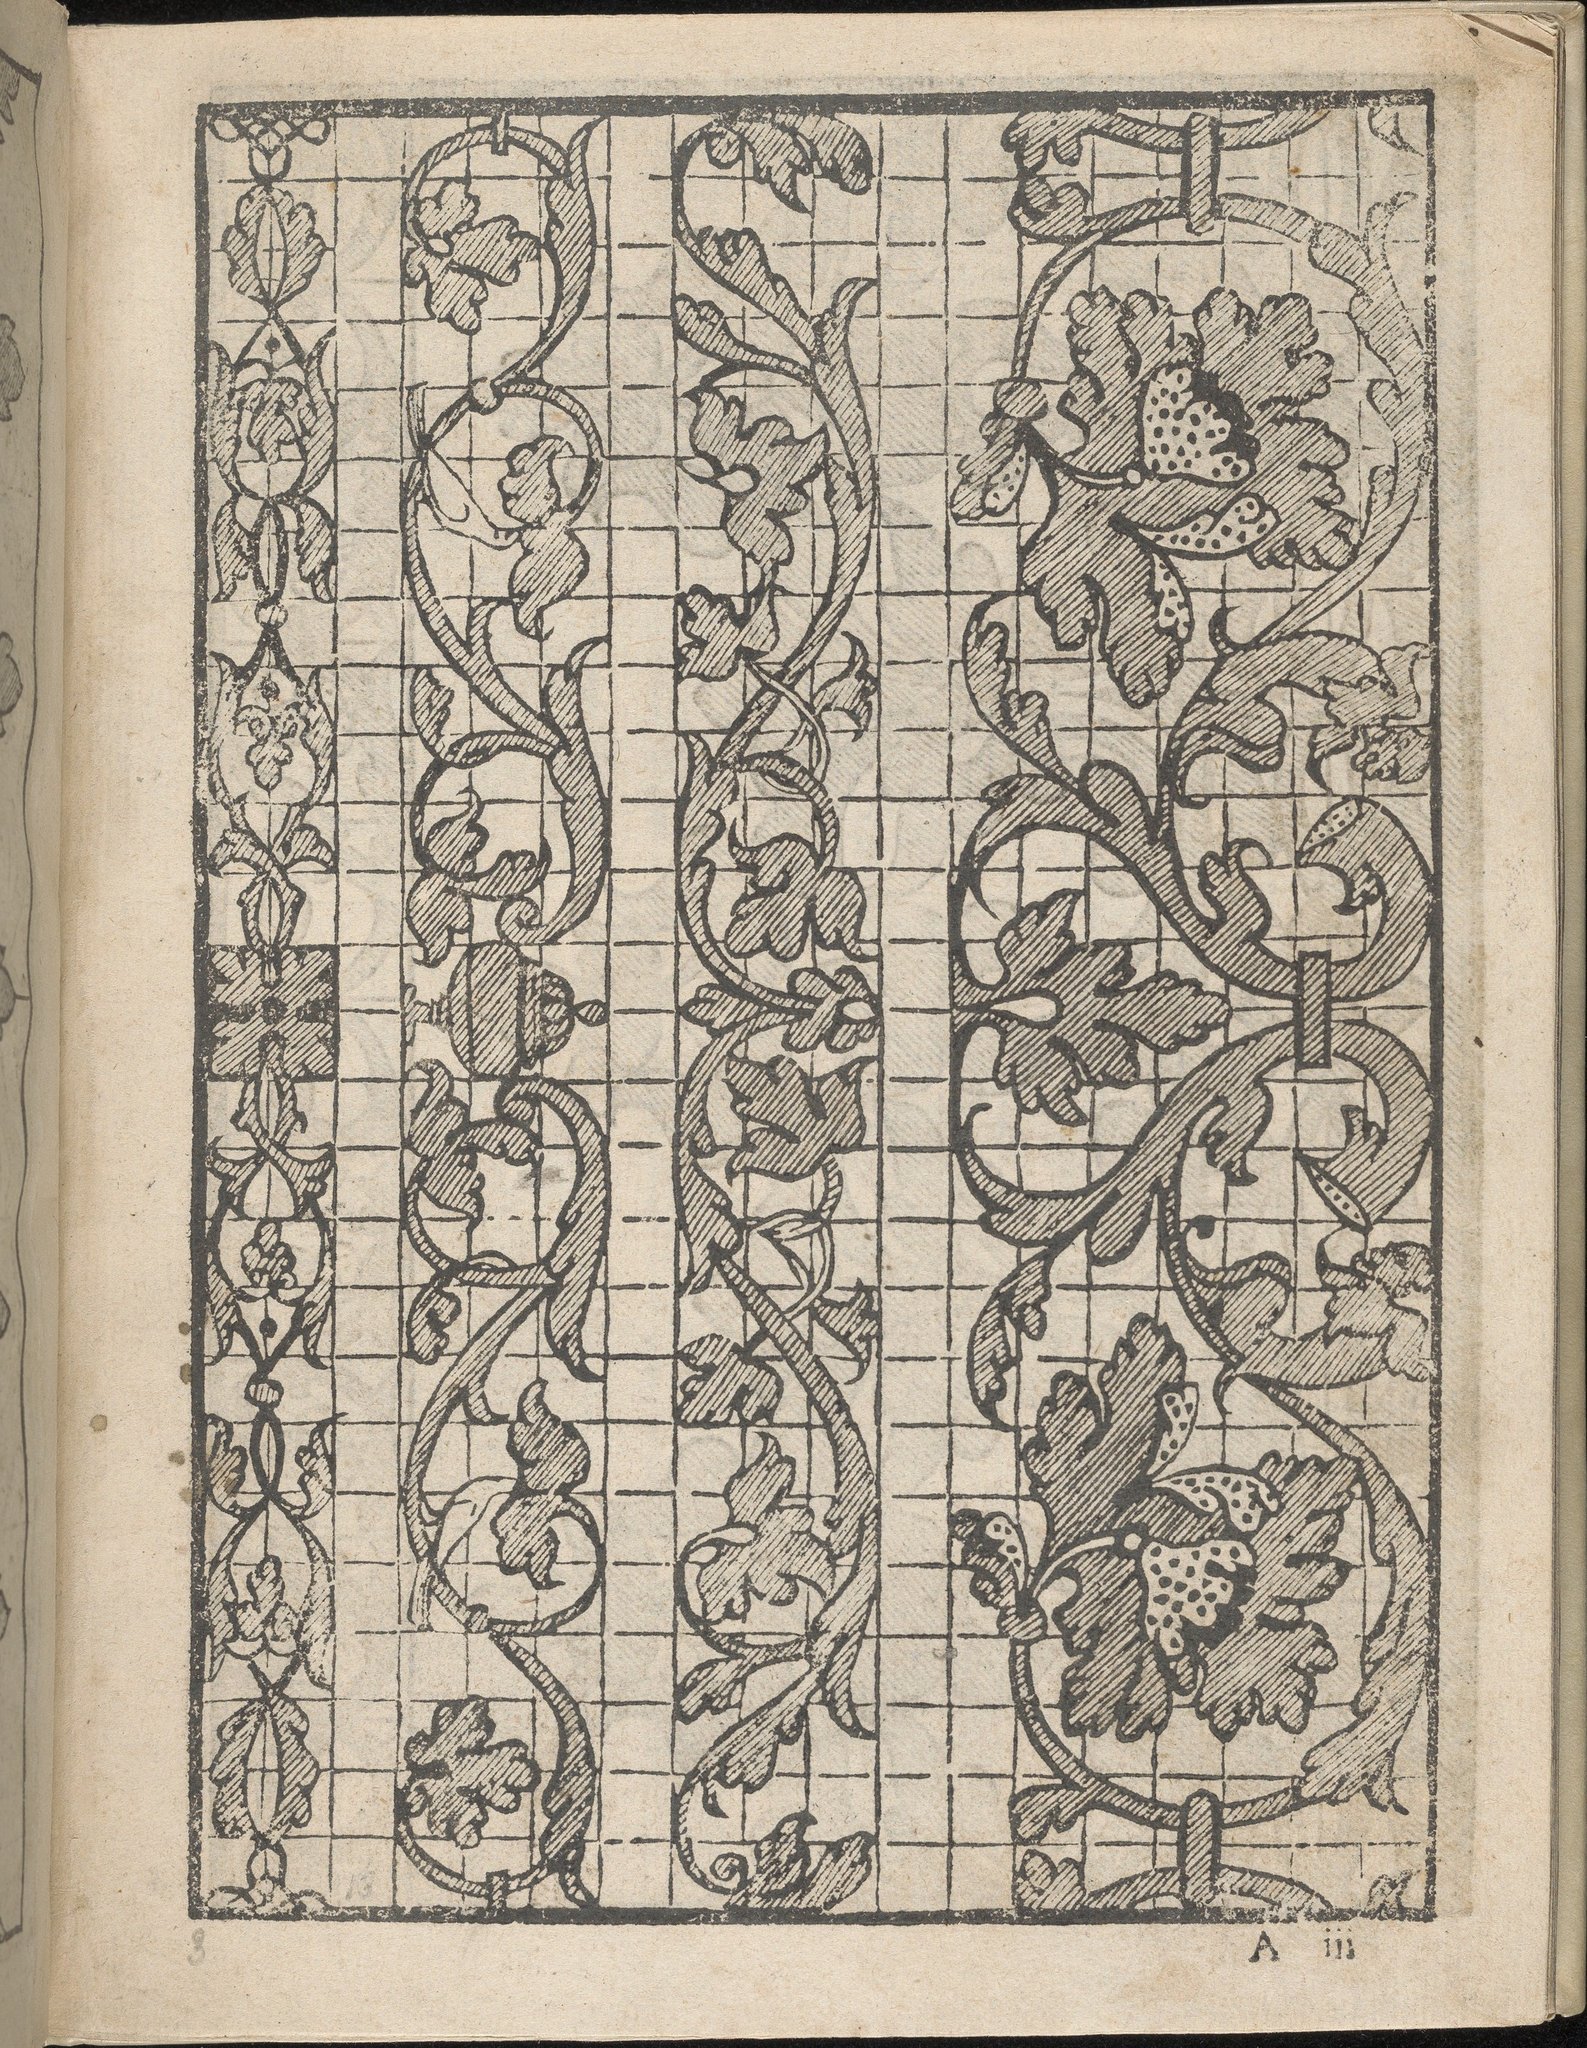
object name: book print ornament architecture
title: Lucidario di Recami, page 2 (verso)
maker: iseppo foresto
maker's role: designer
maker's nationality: italian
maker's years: 1520-1580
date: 1564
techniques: woodcut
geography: italy